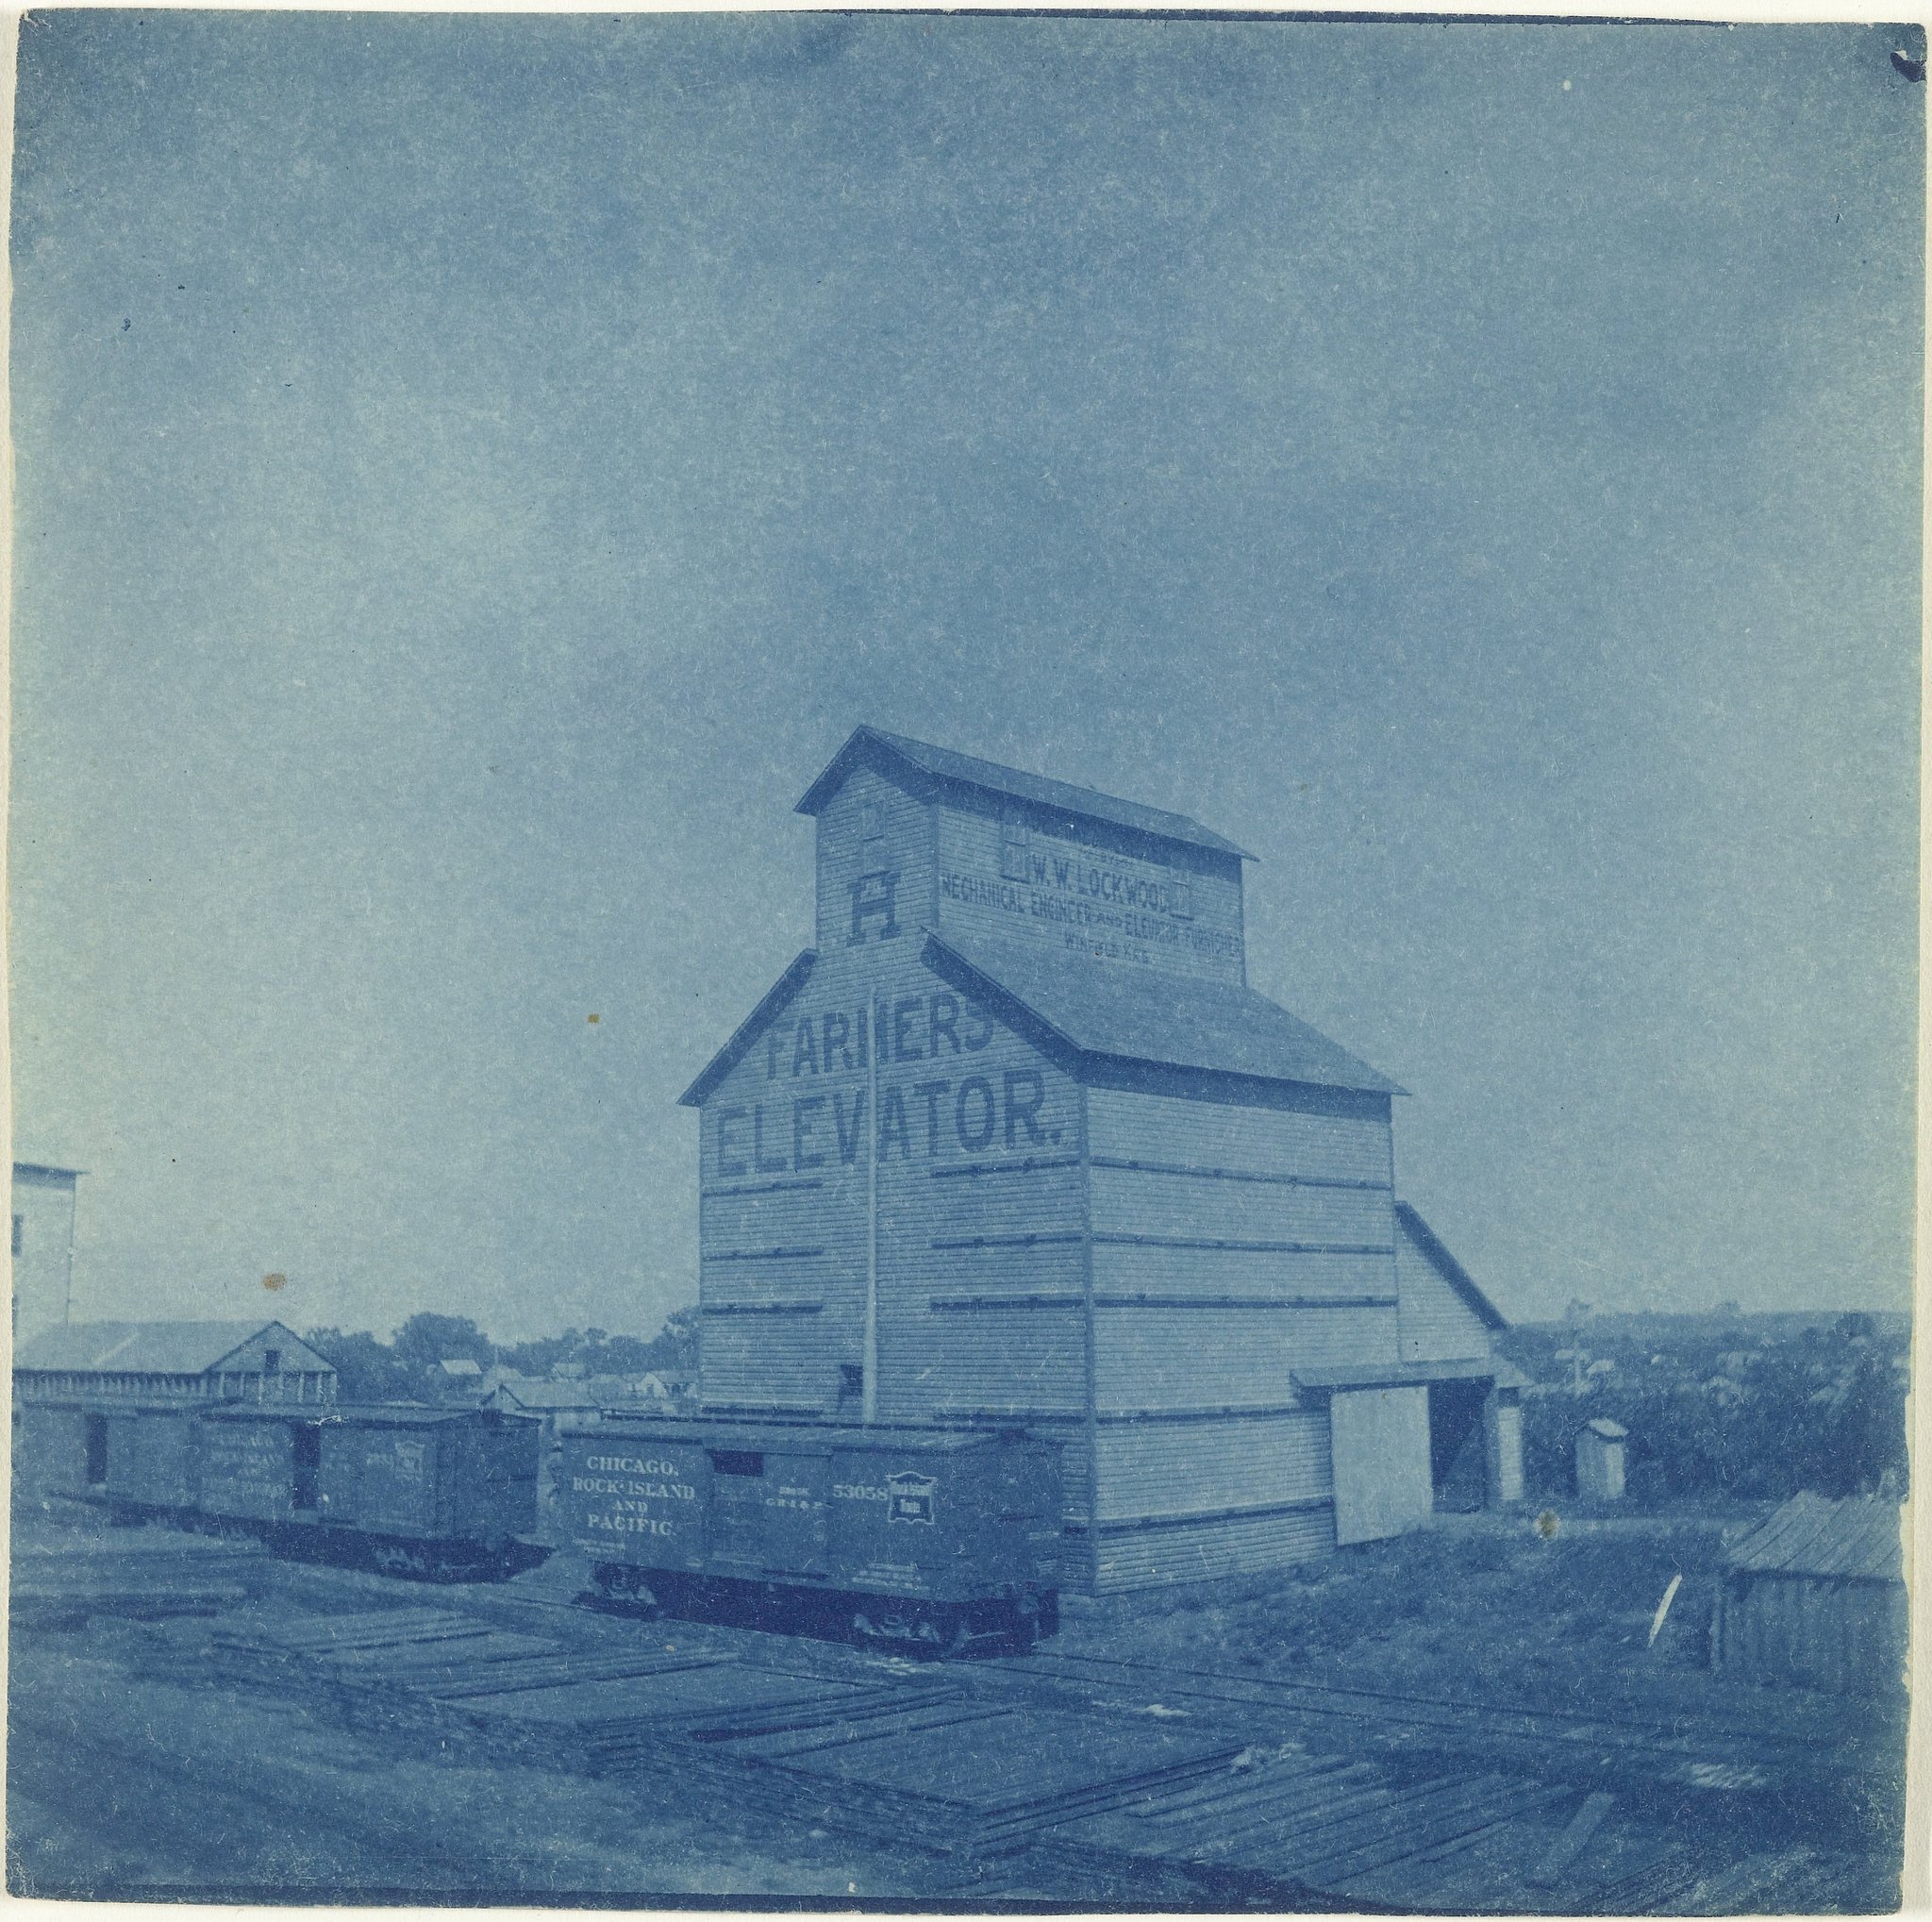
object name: photograph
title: Graanelevator en goederentrein te Kingfisher, Oklahoma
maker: Anonymous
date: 1905-1908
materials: paper, photographic support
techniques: cyanotype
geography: kingfisher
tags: storing in silo ~ harvest, freight train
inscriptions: date: ‘AUG 1900’, annotation: ‘WFarmers Elev. / King Fisher O.Y.’